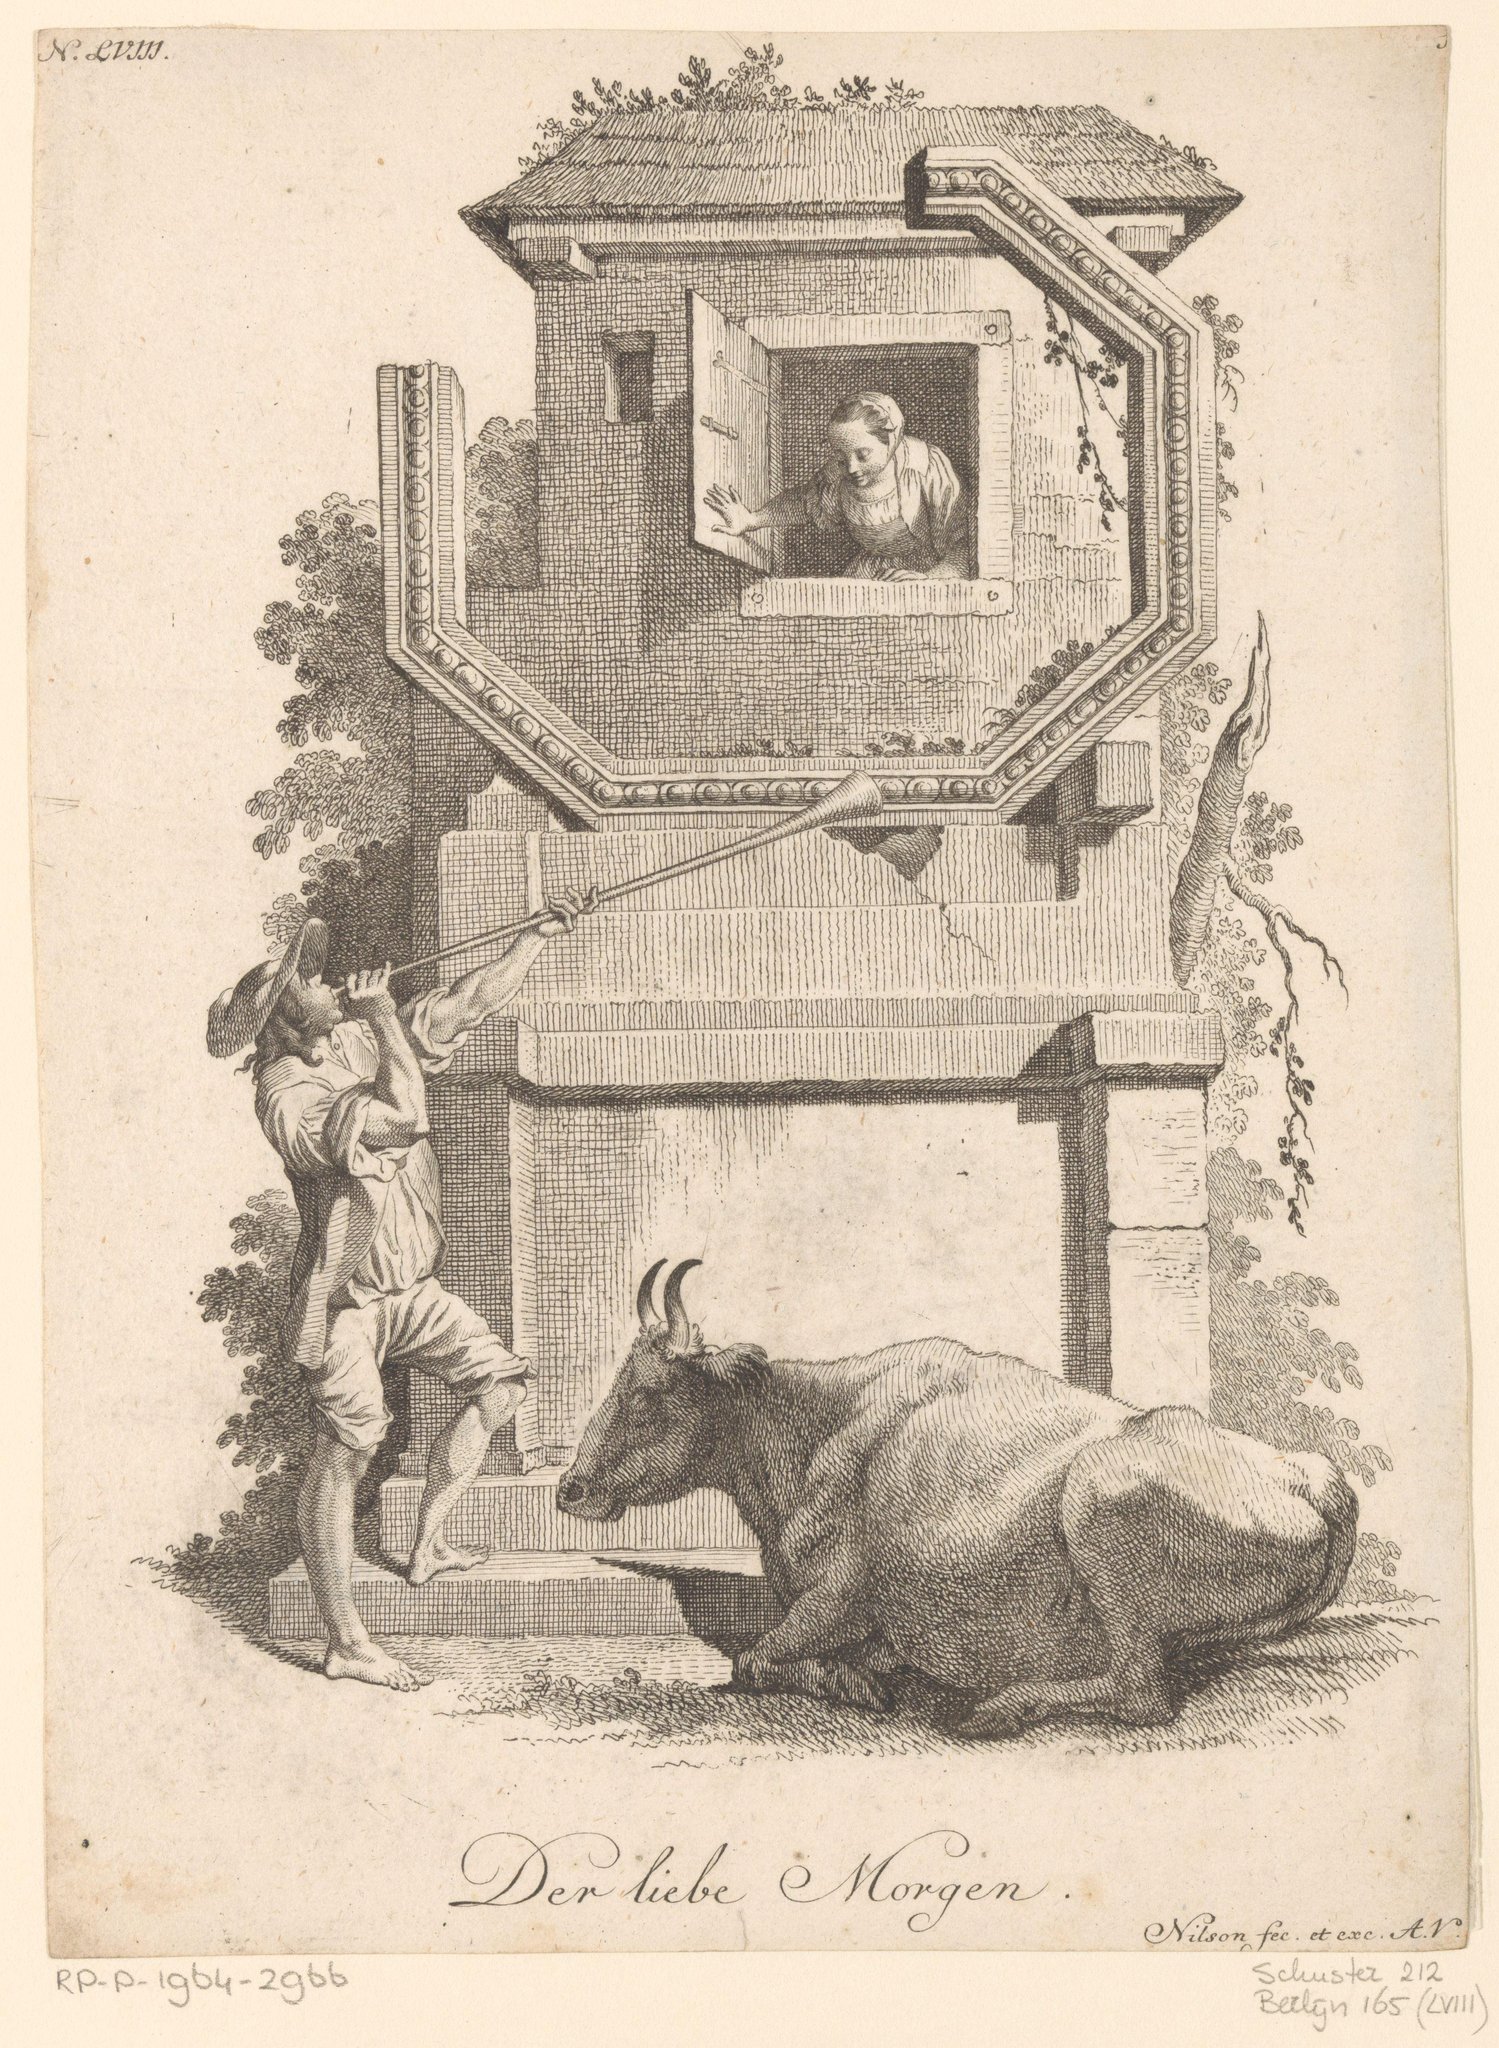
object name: print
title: Dagdelen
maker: johann esaias nilson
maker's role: draughtsman, print maker, publisher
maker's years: 1721-1788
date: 1731-1788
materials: paper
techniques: etching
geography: augsburg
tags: making music; musician with instrument, morning, pastorals, arcadian scenes, couple of lovers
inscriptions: collector's mark: Lugt 2760, collector's mark: Lugt 2228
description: Een herder staat voor een fantasiegebouw en blaast op een instrument. Zijn geliefde kijkt en luistert vanuit een raam met luik naar hem. Naast de herder ligt een rund. Uitgeversnummer LVIII.